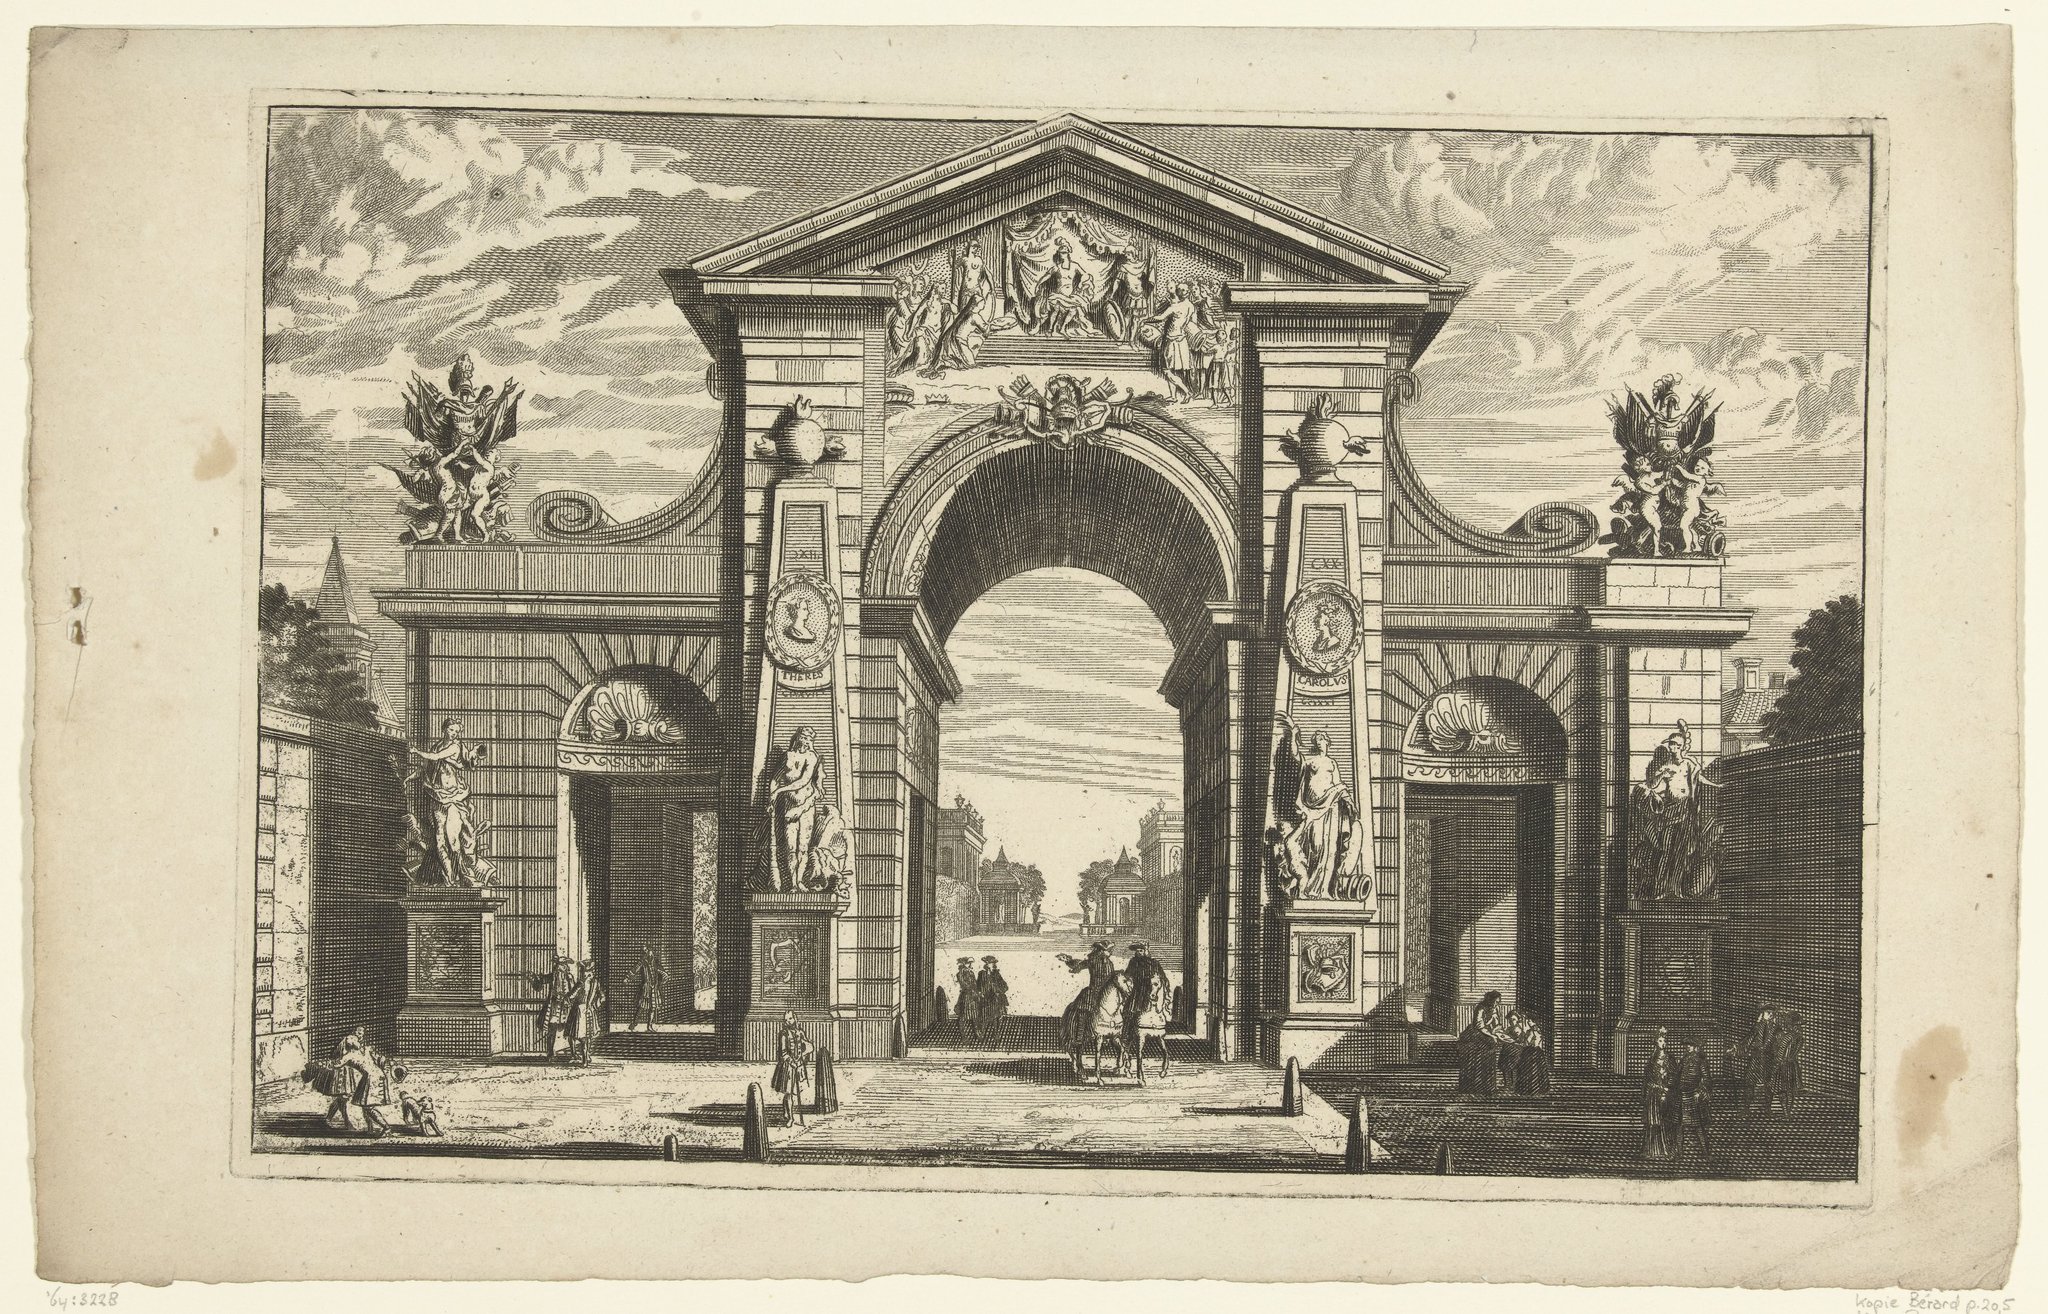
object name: print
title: Stadspoort in de vorm van een triomfboog met drie doorgangen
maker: Anonymous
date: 1600-1699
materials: paper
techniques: etching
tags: triumphal arch, city-gate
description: De middelste doorgang is hoger dan de anderen en heeft bovenaan een fronton met een bas-reliëf. Blad 6 uit serie van 6 bladen, tegenzijdige kopie naar blad uit de serie Second Liure d'Arc de Triomphe et Porte de Ville uitgegeven door Daniel Marot (I).